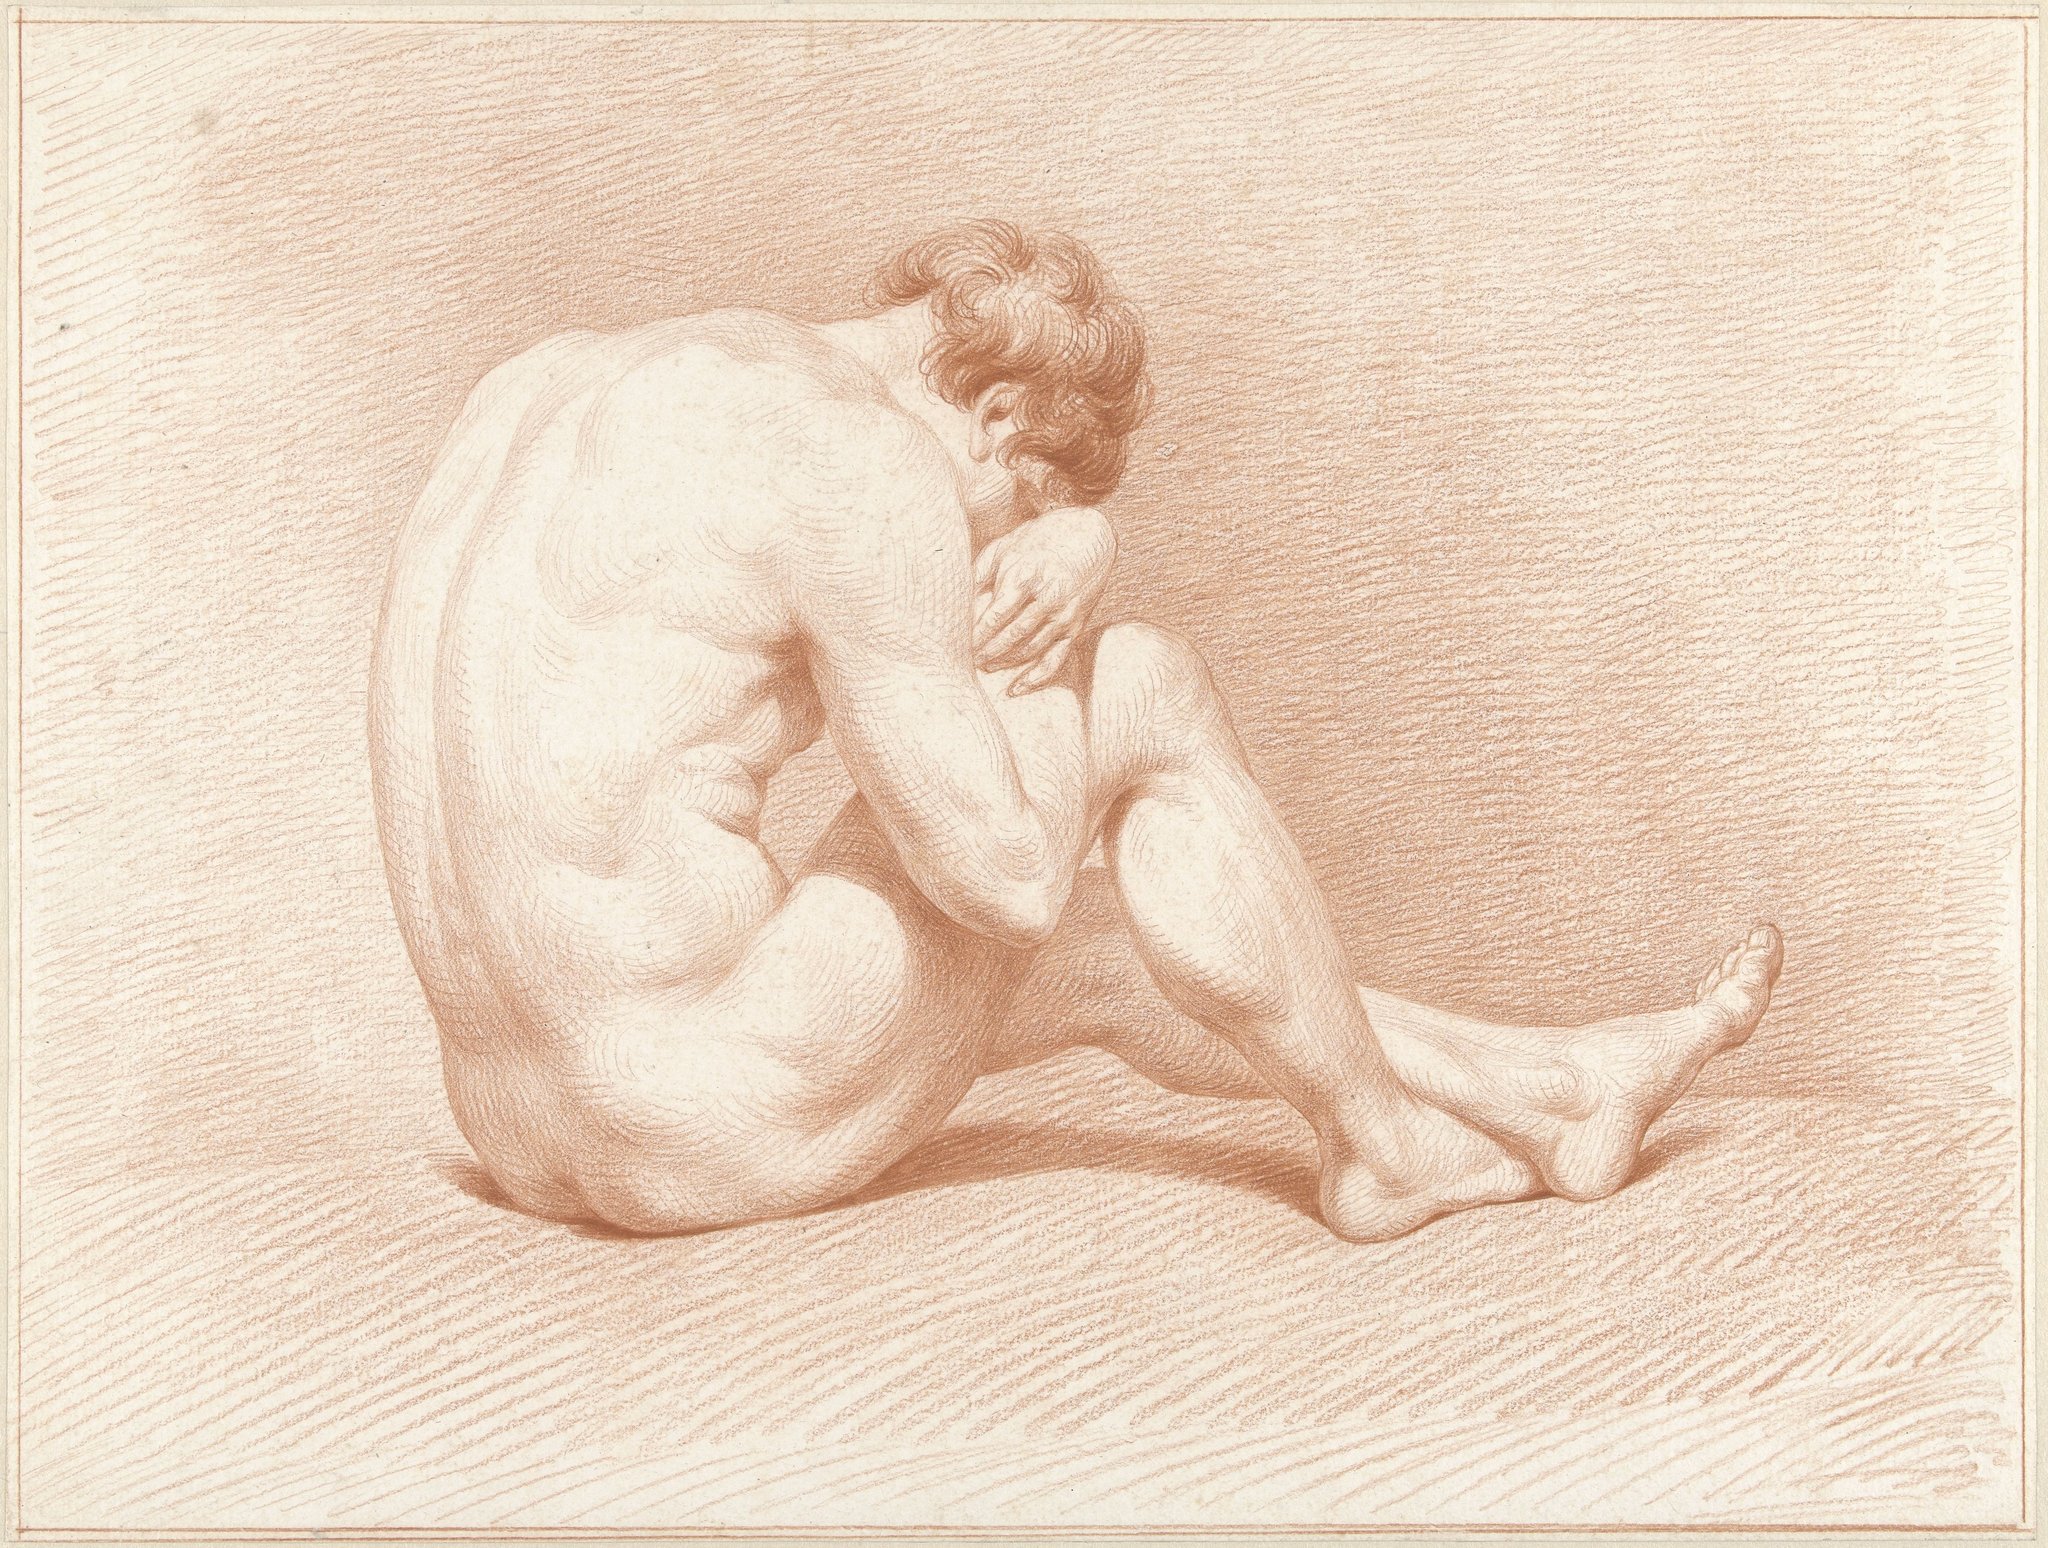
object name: drawing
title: Zittend mannelijk naakt, het hoofd op de knie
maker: jacob willemz. de vos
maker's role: draughtsman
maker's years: 1774-1844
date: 1809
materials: chalk, paper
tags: sitting with arms or elbows on the knees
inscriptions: inscription: ‘Jb d Voswillemsz 1809’